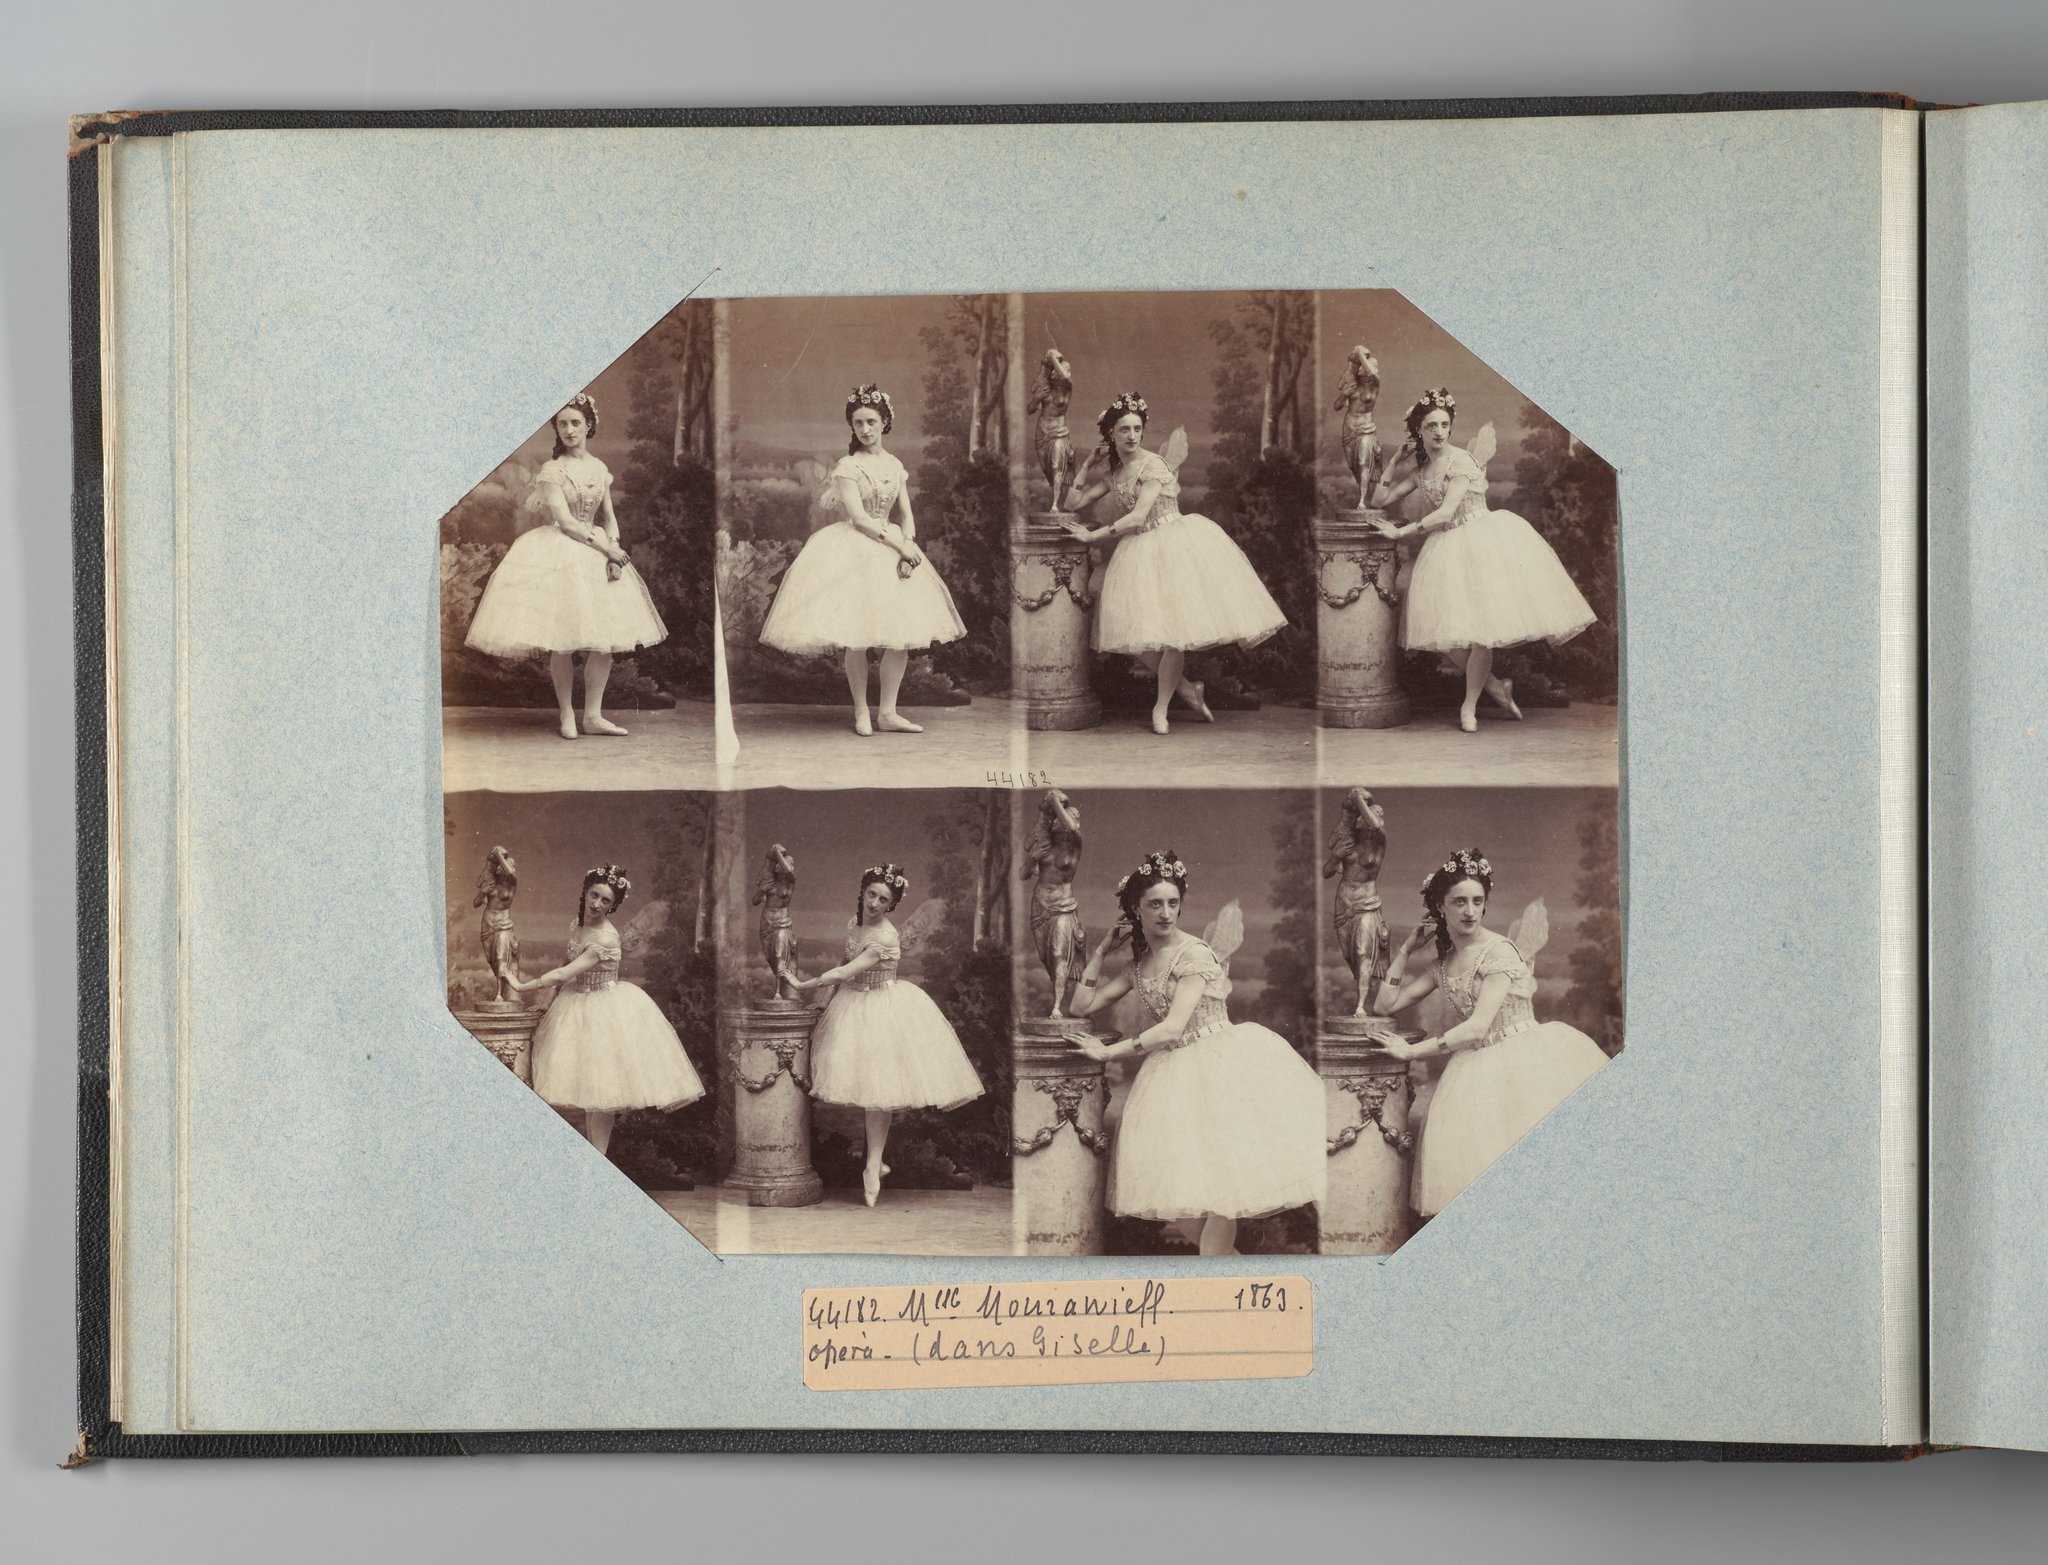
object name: photograph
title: Mlle Mourawieff dans Gisèle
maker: andré-adolphe-eugène disdéri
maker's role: artist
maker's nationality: french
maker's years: 1819-1889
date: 1863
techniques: albumen silver print, glass negative